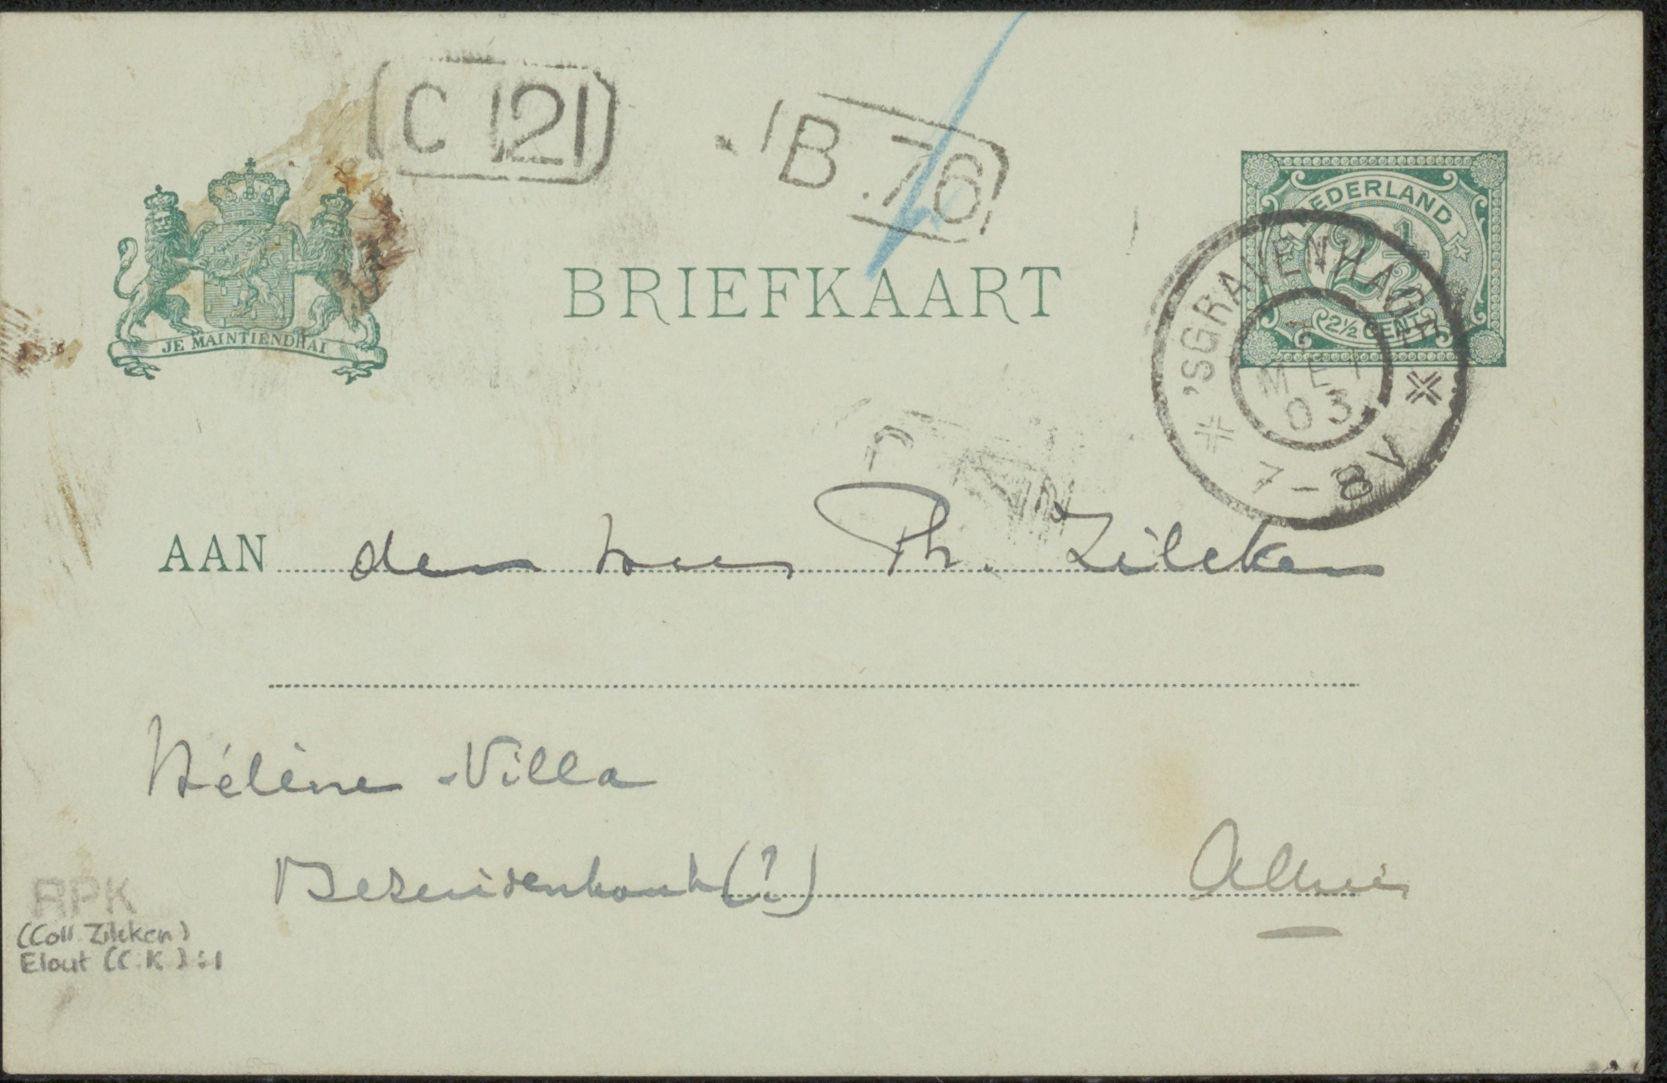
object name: postcard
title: Briefkaart aan Philip Zilcken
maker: cornelis karel elout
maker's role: journalist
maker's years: 1870-1947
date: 1903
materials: cardboard, ink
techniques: pen, writing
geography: the hague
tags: the hague, painter, draughtsman, philip zilcken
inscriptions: collector's mark: ‘RPK’